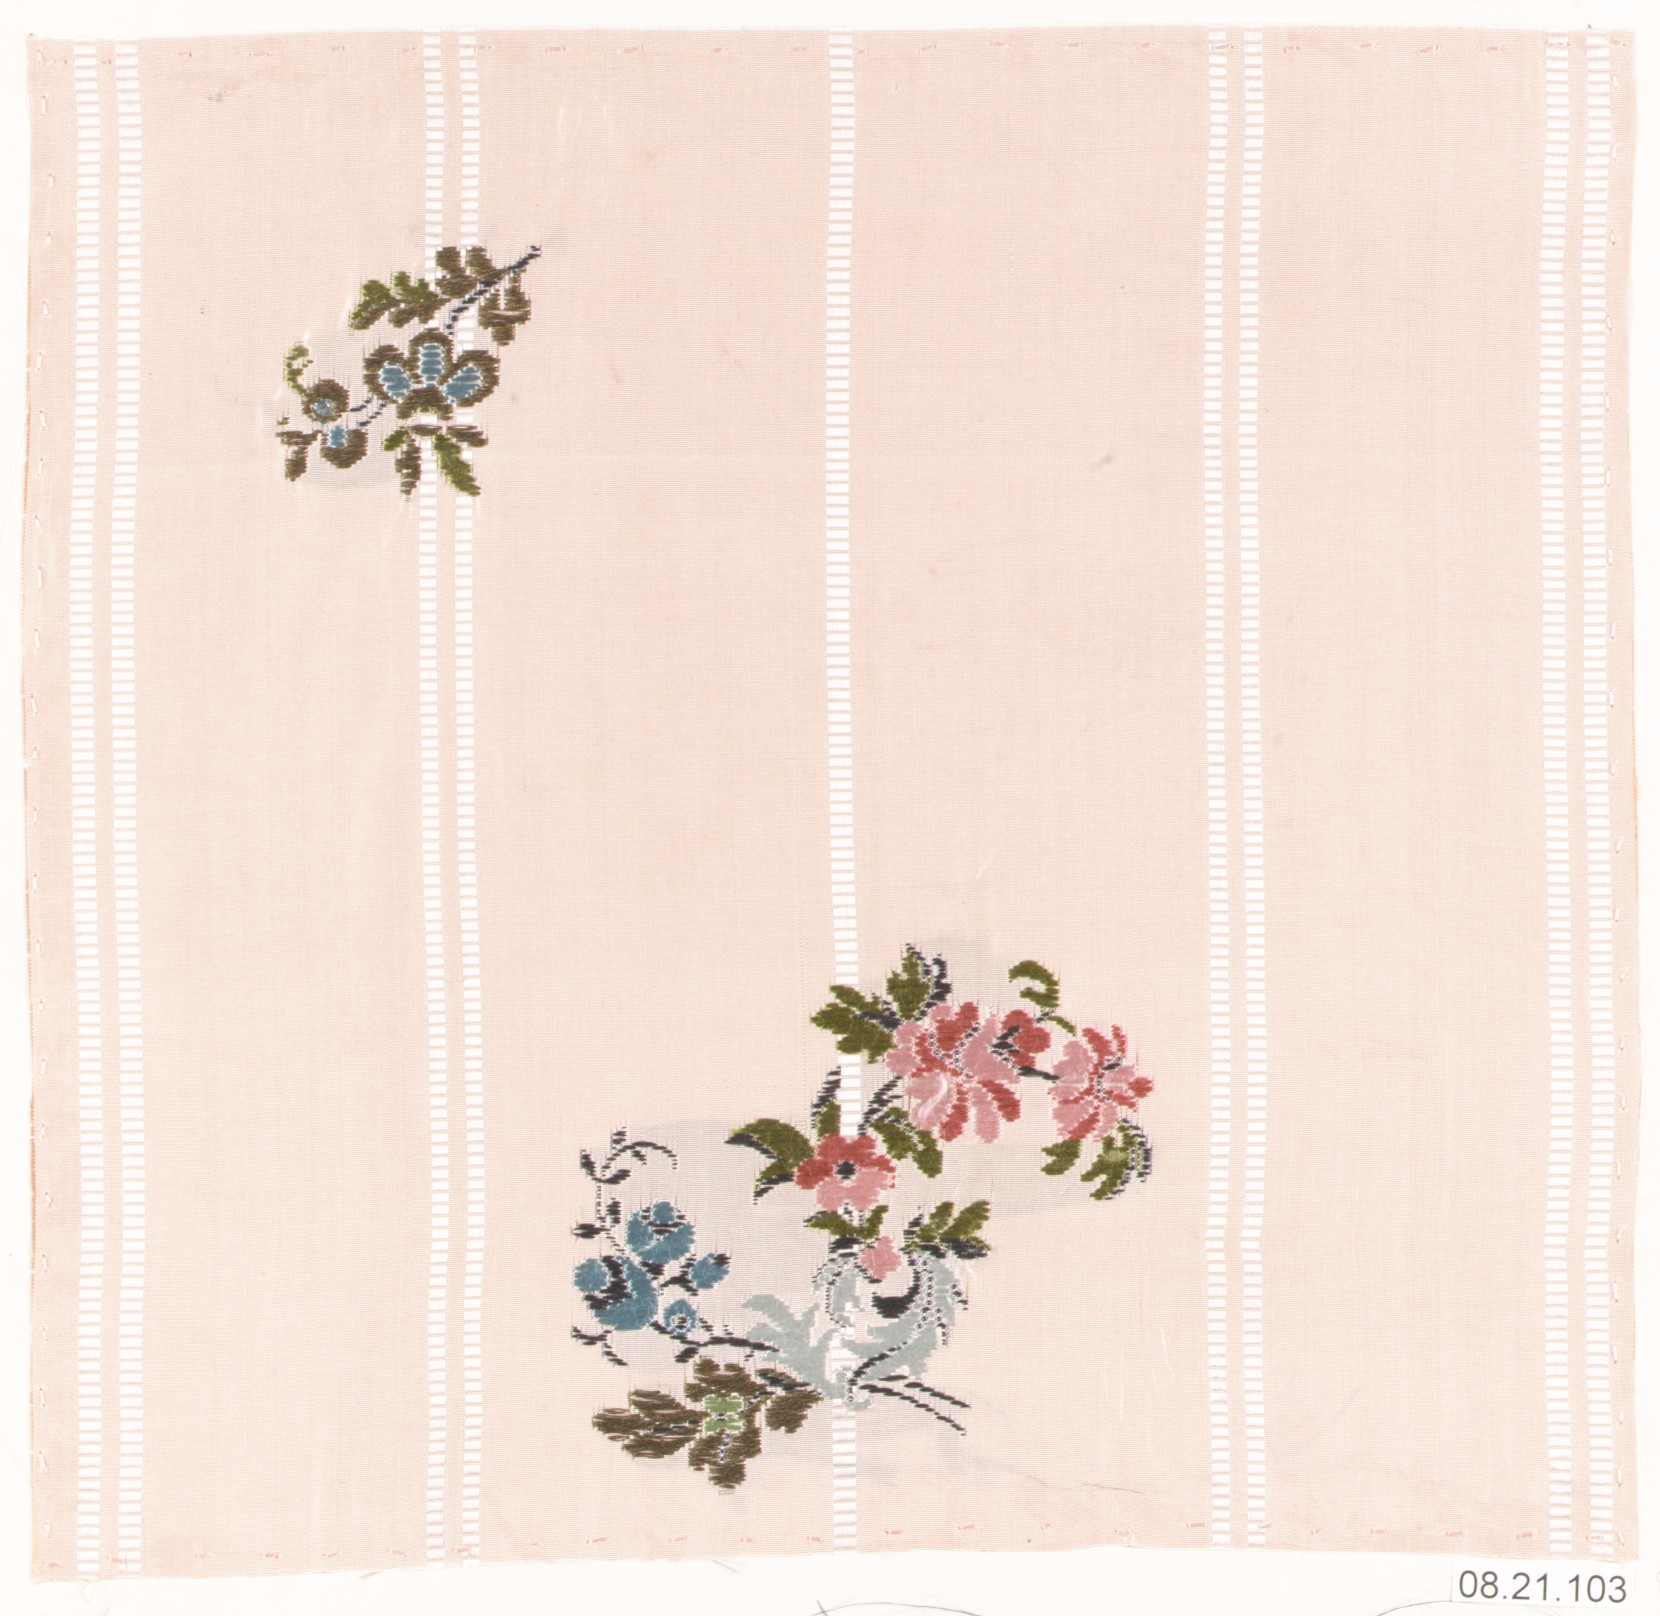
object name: textile sample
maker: Anonymous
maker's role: designer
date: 1900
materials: silk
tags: flowers